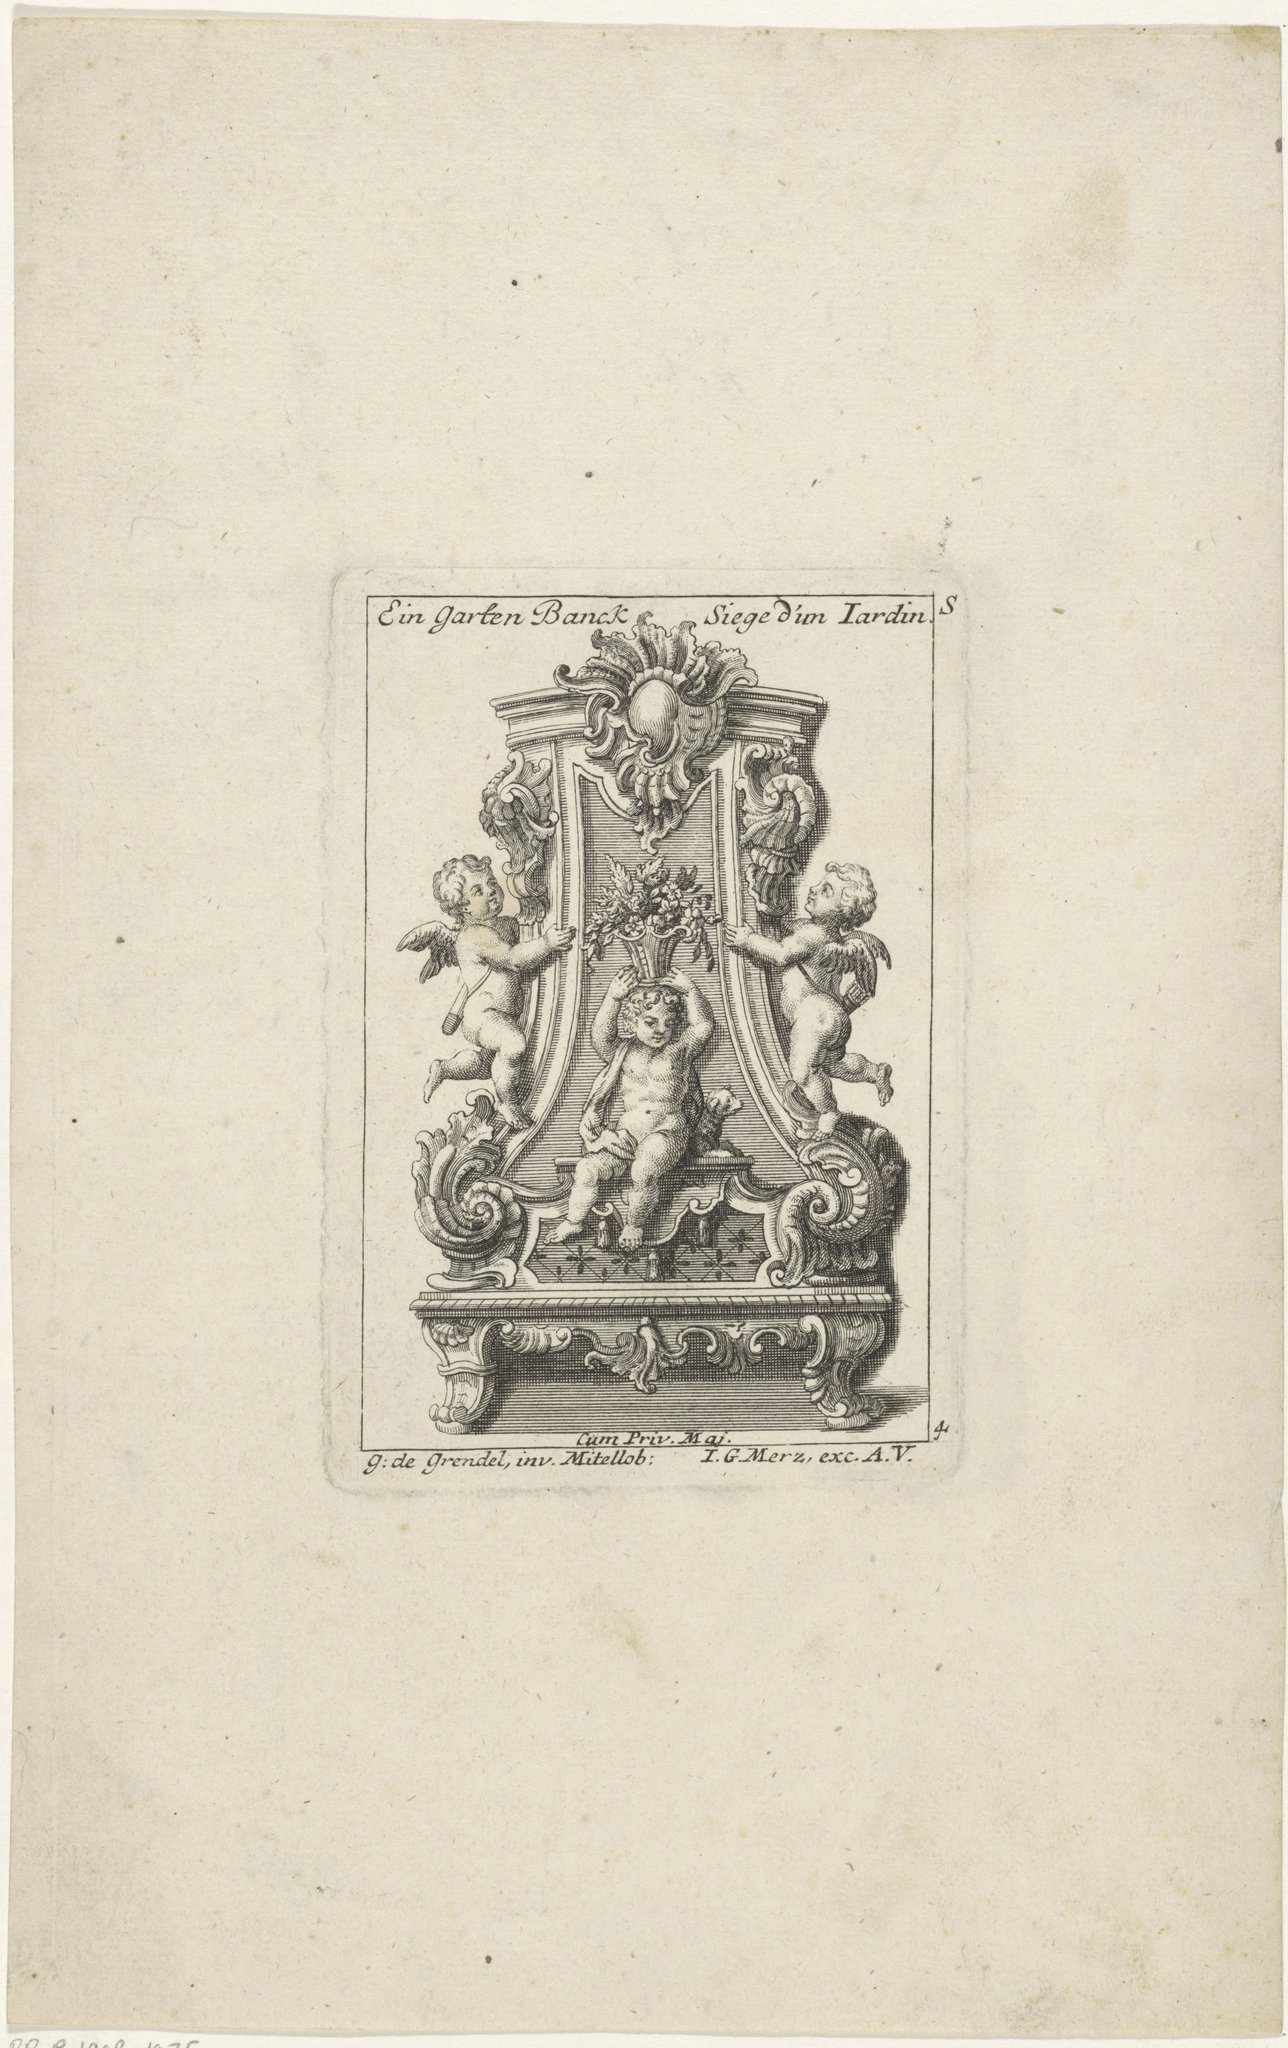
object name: ornament print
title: Neu inventirte Hollaendische Camine, Erster Theil, serie S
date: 1709-1762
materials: paper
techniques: engraving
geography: middelburg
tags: rocaille ornament, garden ornaments, cupids: 'amores', 'amoretti', 'putti'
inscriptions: collector's mark: Lugt 2228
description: Ontwerp voor een tuinbank met aan weerszijden en in het midden een putto. De middelste putto draagt een mand met bloemen boven het hoofd. De tuinbank is versierd met rocailleornamenten.